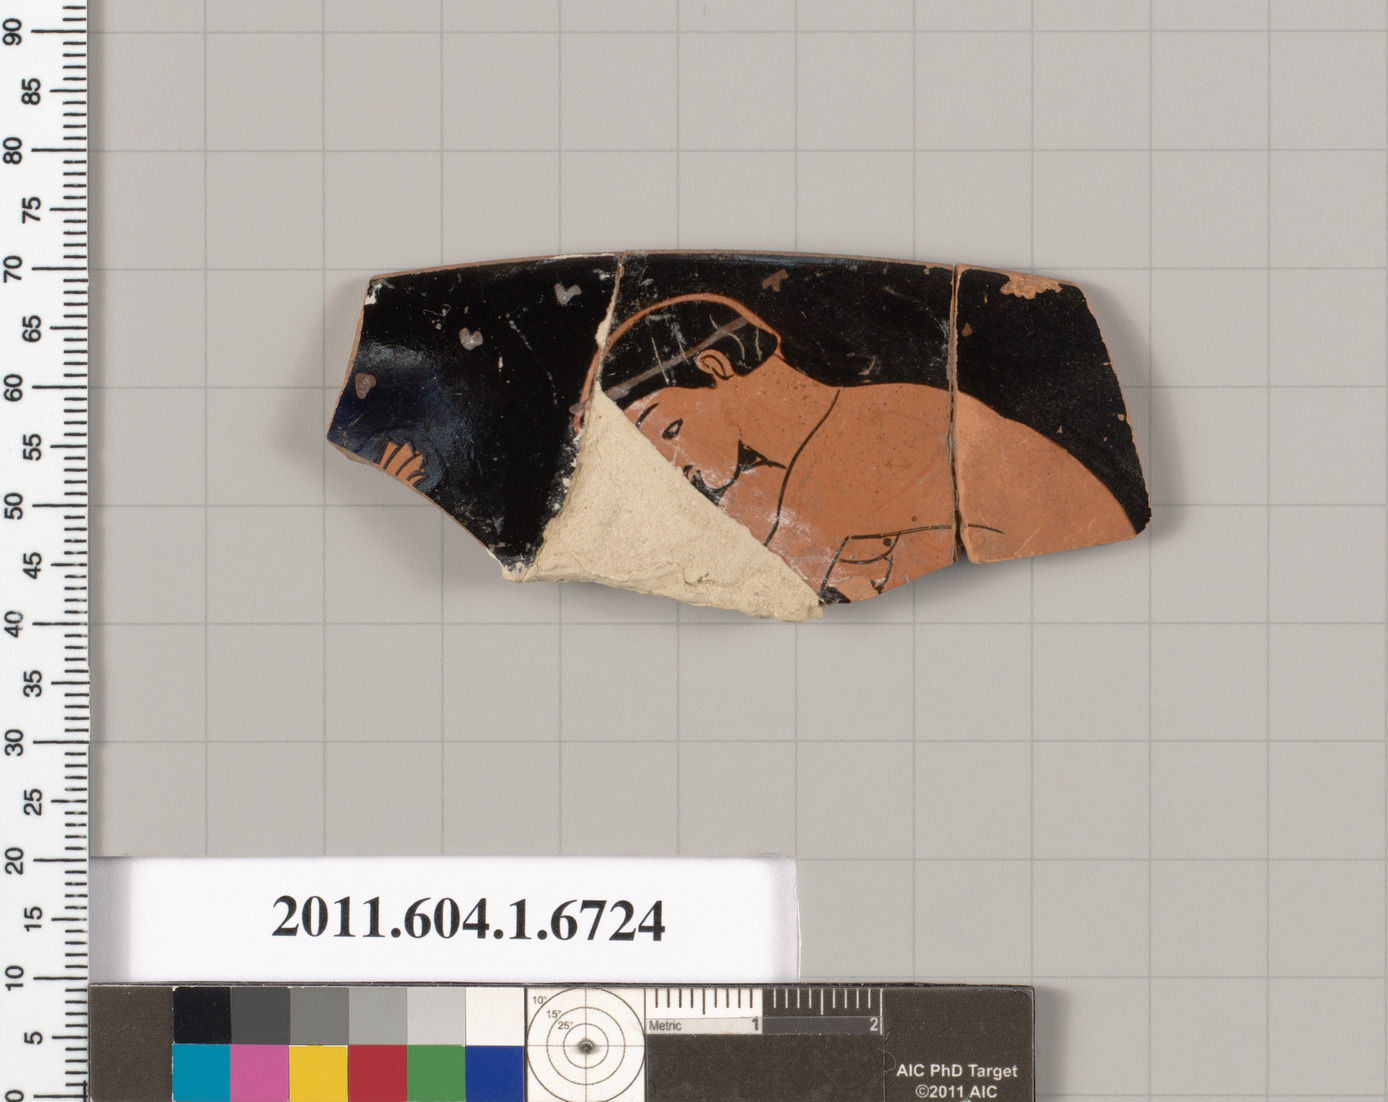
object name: kylix fragment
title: Terracotta rim fragment of a kylix (drinking cup)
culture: greek, attic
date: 490-470 BCE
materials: terracotta